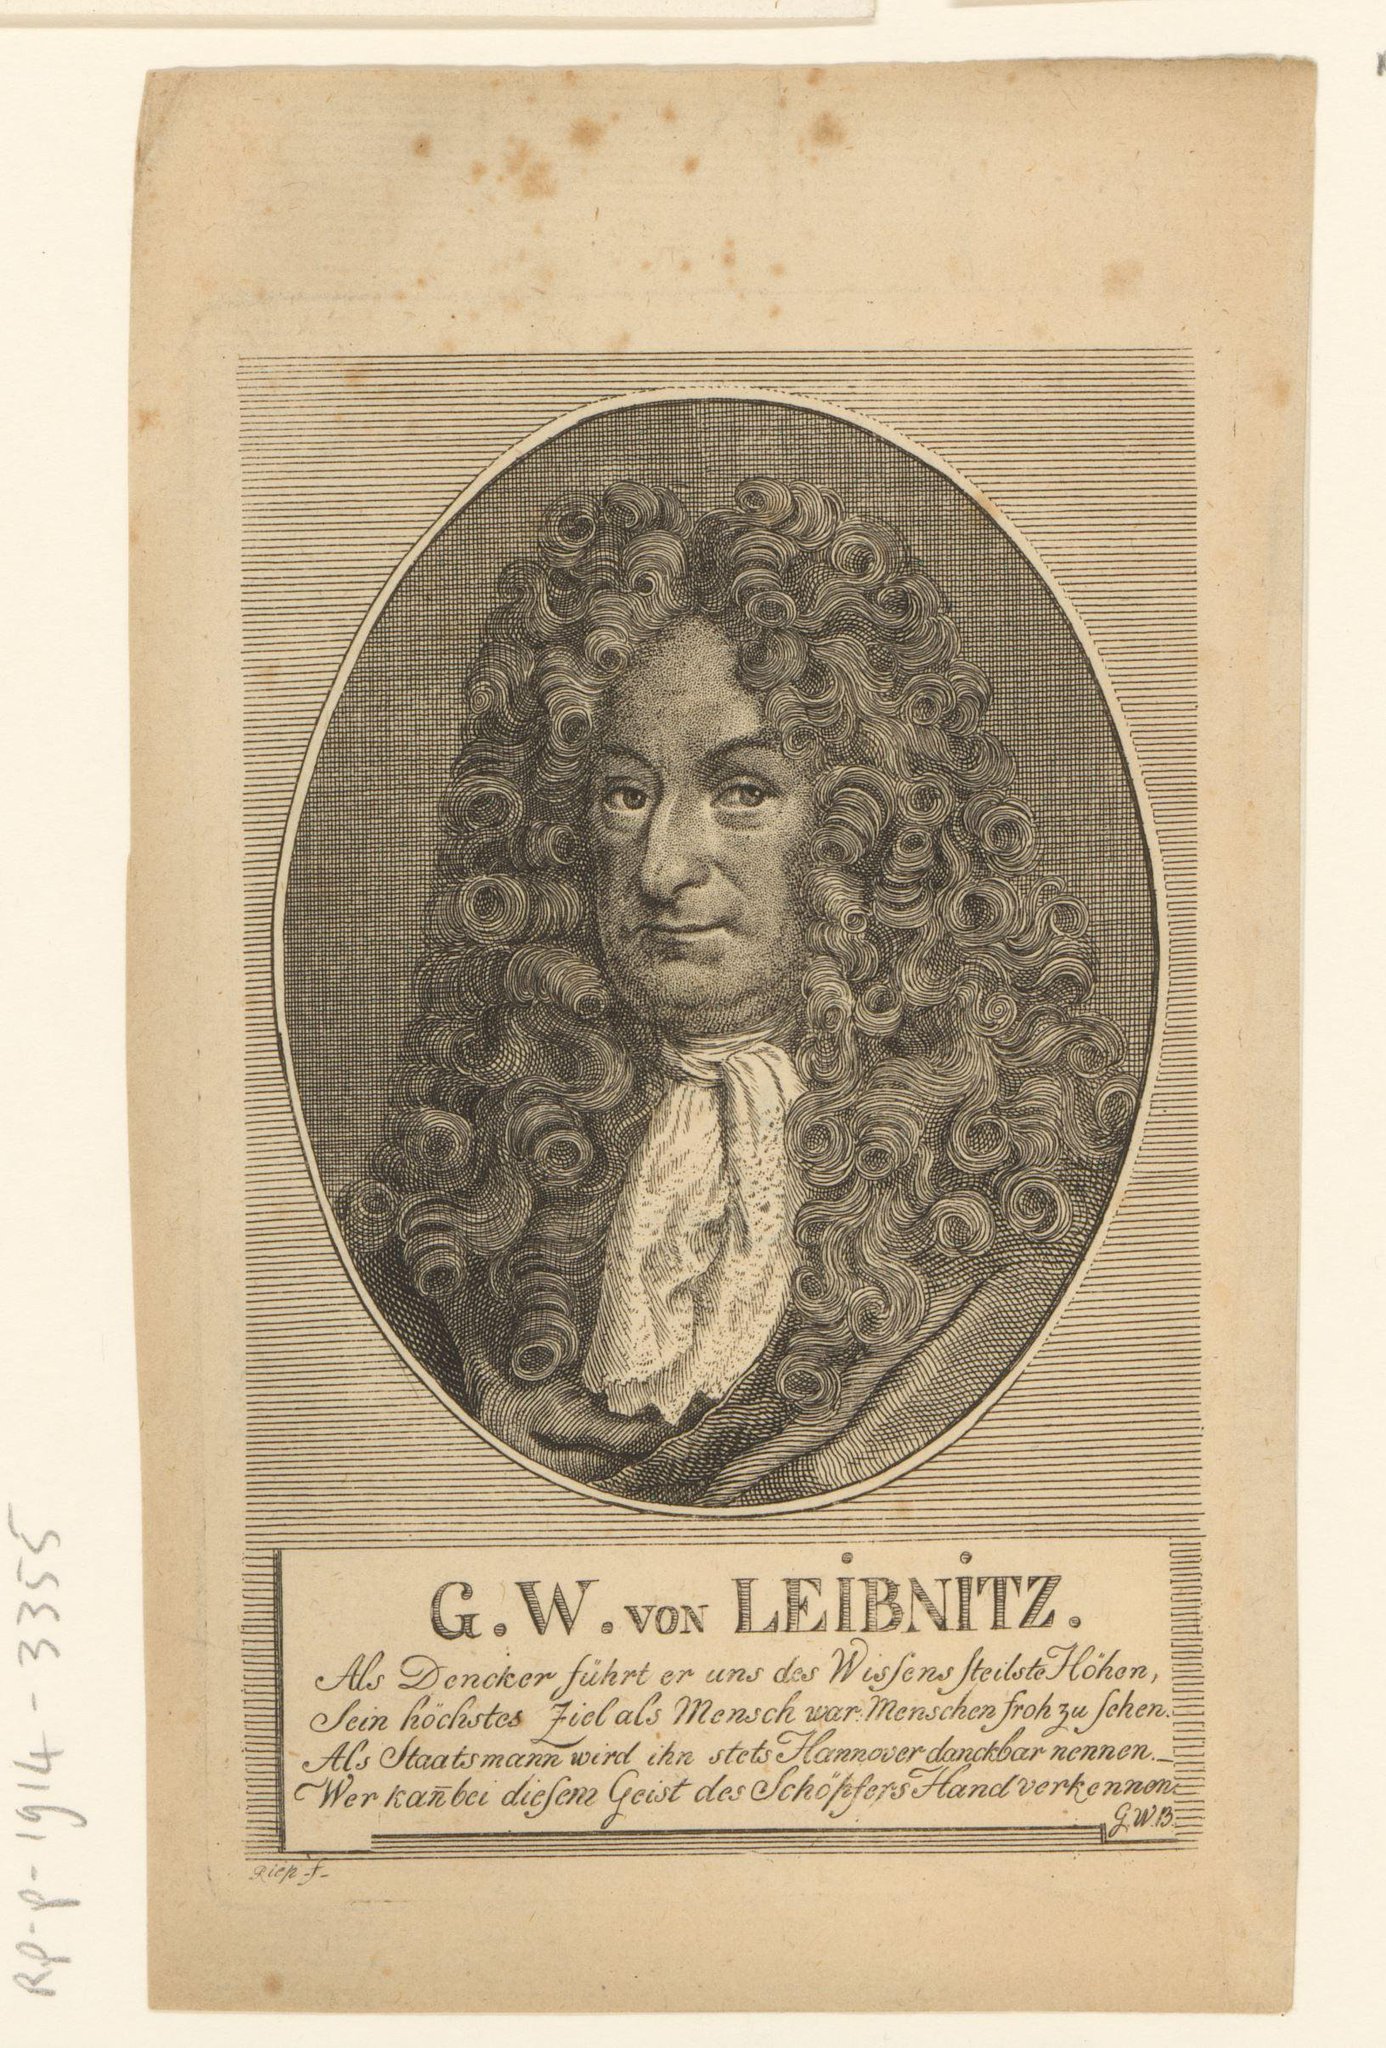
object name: print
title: Portret van Gottfried Wilhelm Leibniz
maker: ernst ludwig riepenhausen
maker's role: print maker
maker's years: 1765-1840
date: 1775-1840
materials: paper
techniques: engraving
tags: historical persons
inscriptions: collector's mark: Lugt 2228